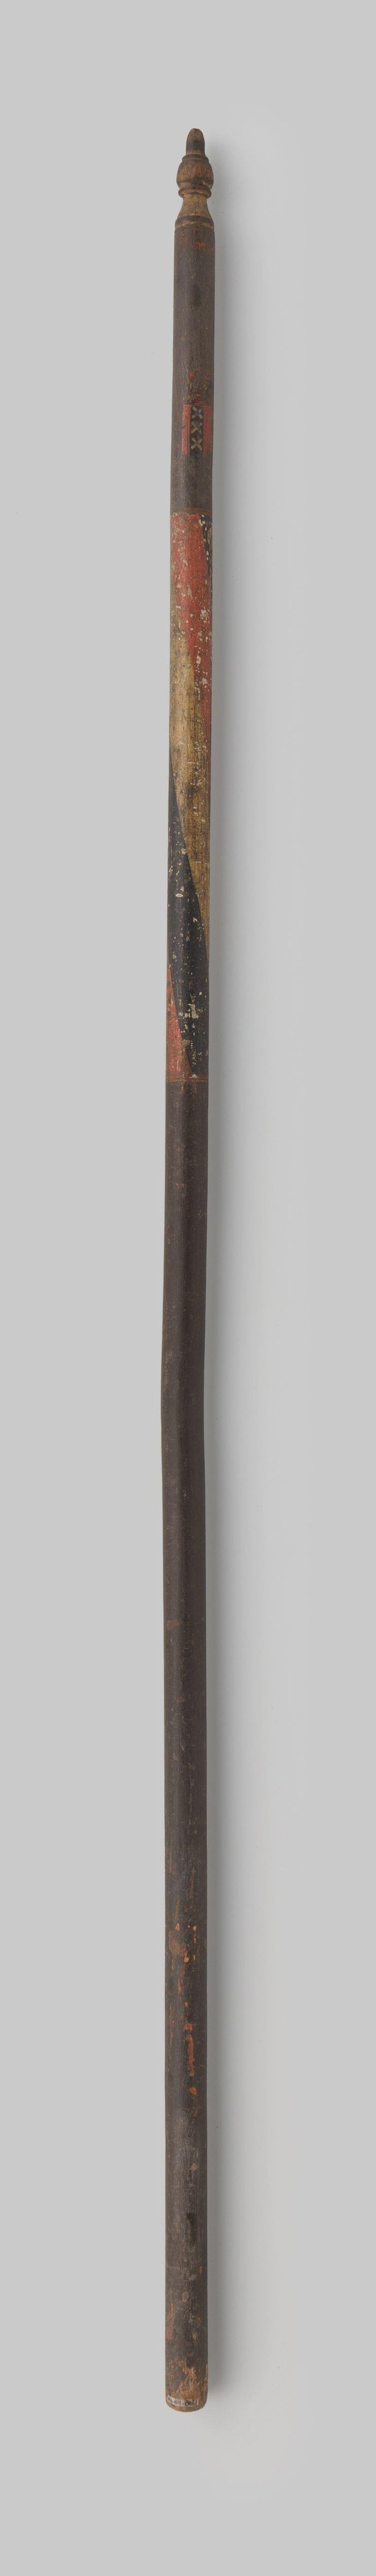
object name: stok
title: Brandmeestersstok met geprofileerde kop en gekroond wapen Amsterdam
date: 1700-1800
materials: oil, wood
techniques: painted, turning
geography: amsterdam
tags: amsterdam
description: Stok met geprofileerde kop. Over de gehele lengte bruin geverfd op één deel na waar de kleuren van Amsterdam in diagonale banen zijn geschilderd. Vlak daarboven gekroond wapen van Amsterdam.